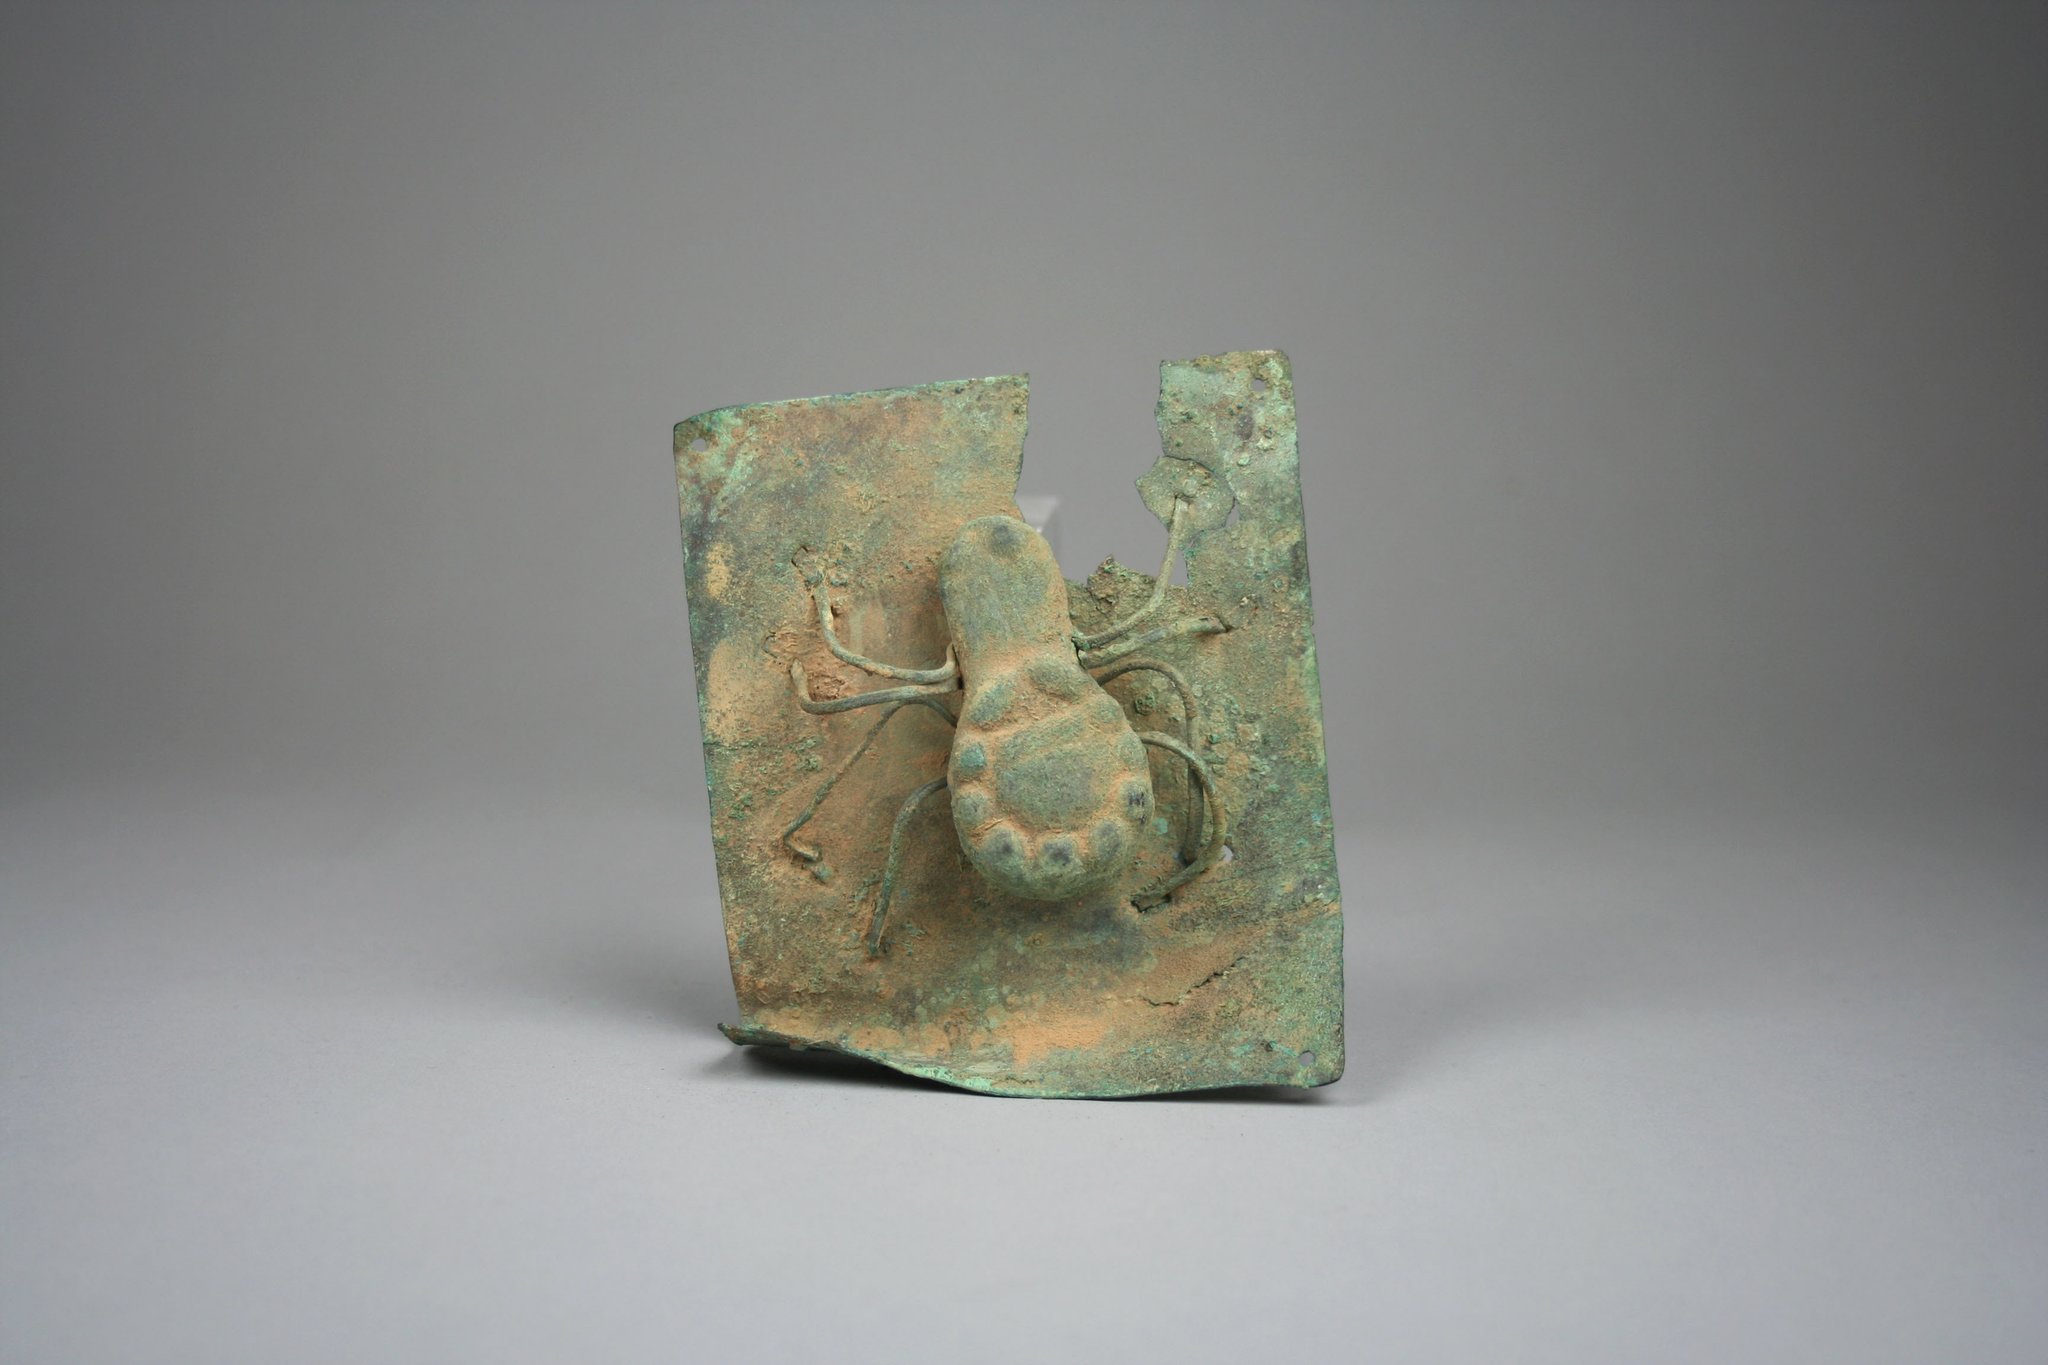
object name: ornament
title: Spider Ornament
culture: moche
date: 501-700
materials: metal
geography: peru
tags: insects